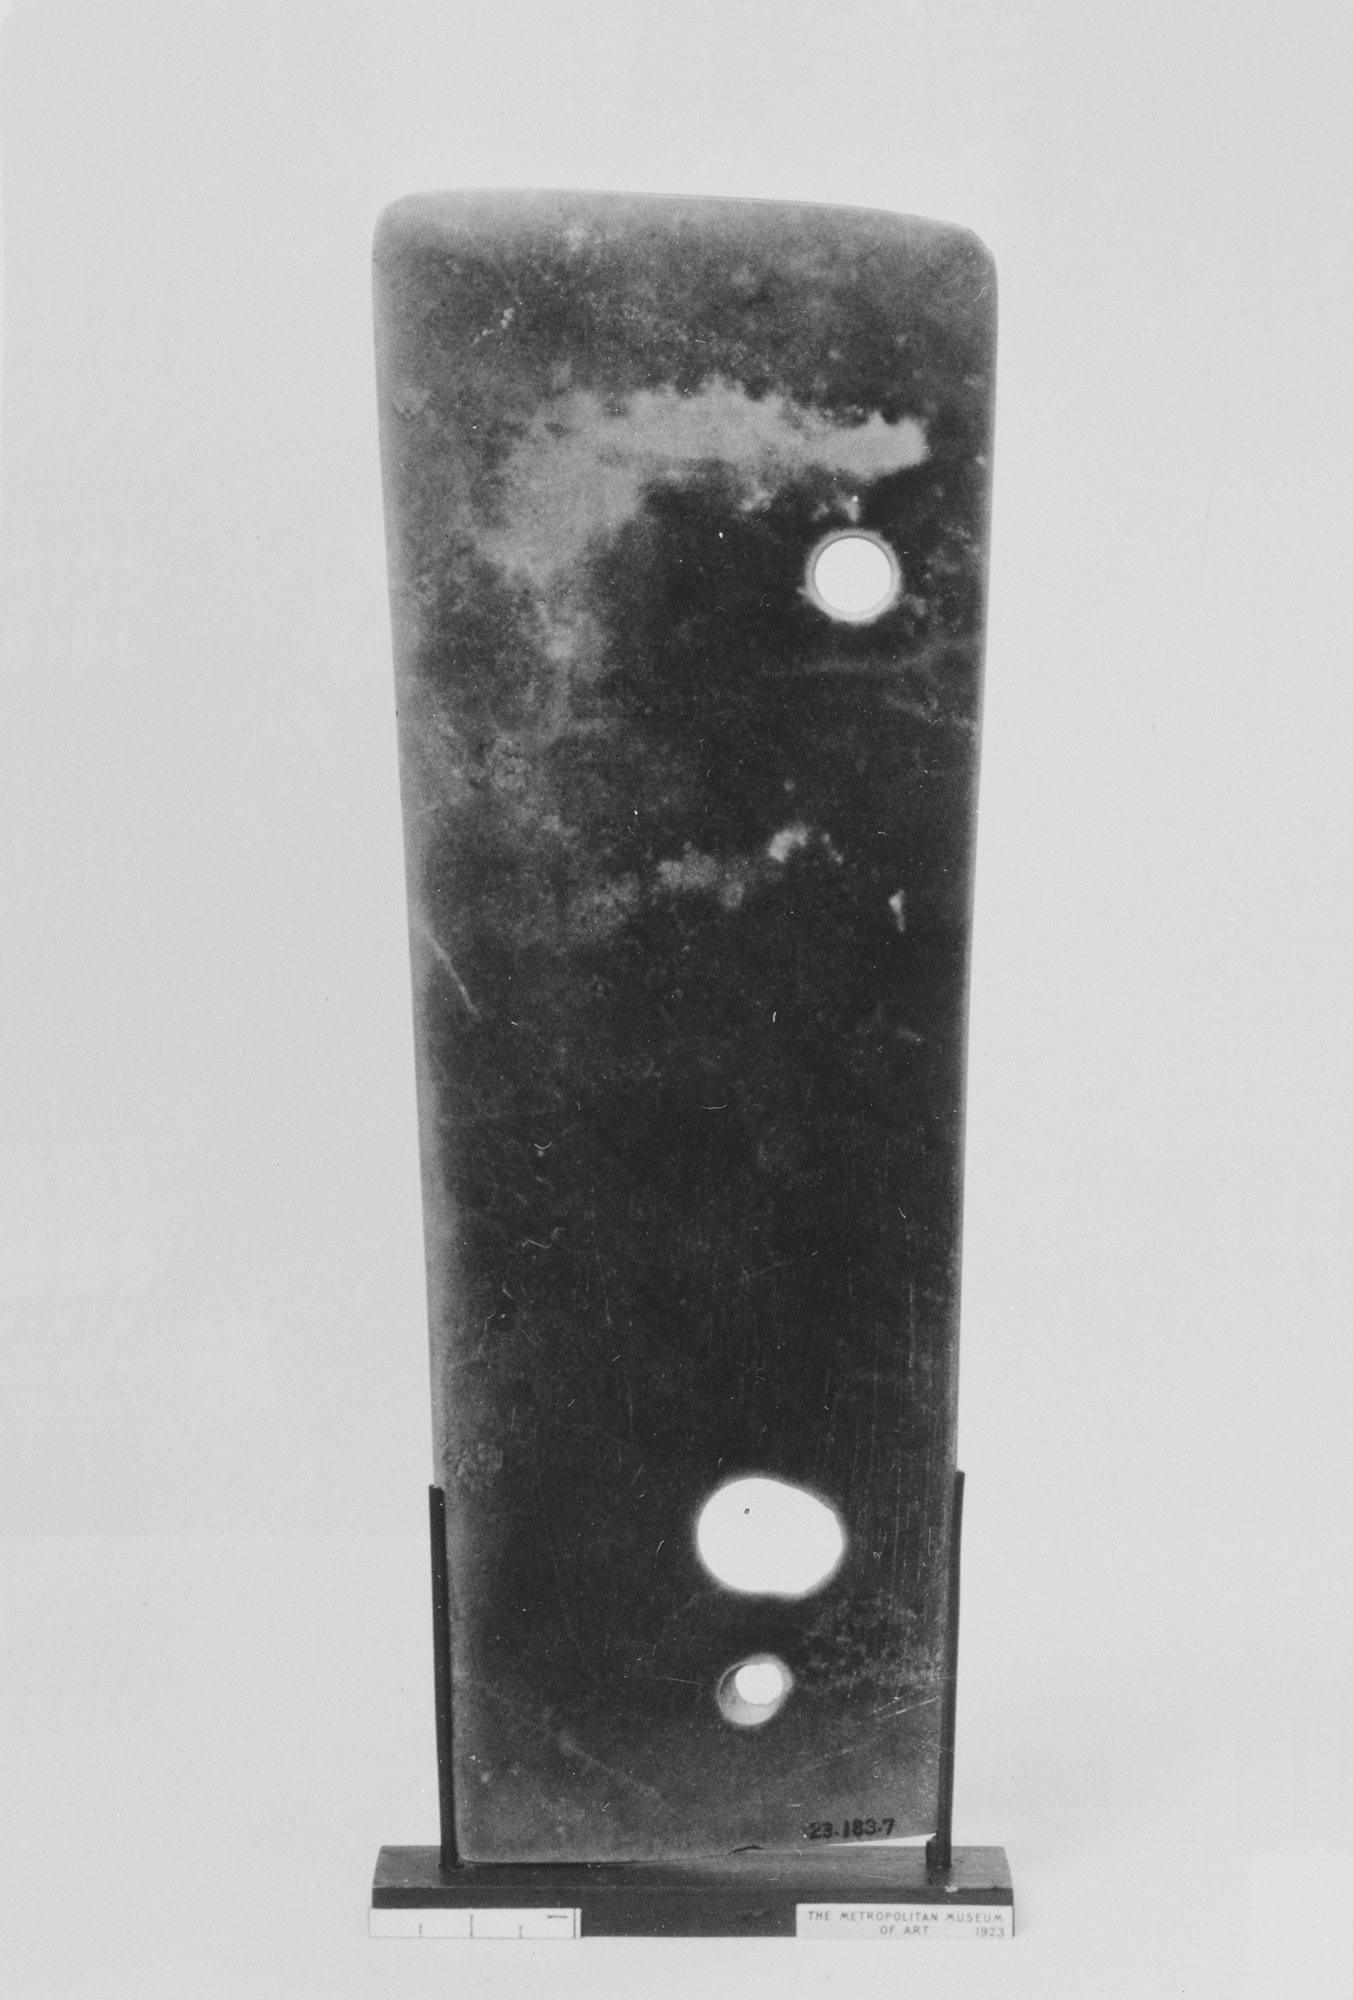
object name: knife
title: Ceremonial blade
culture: chinese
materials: jade